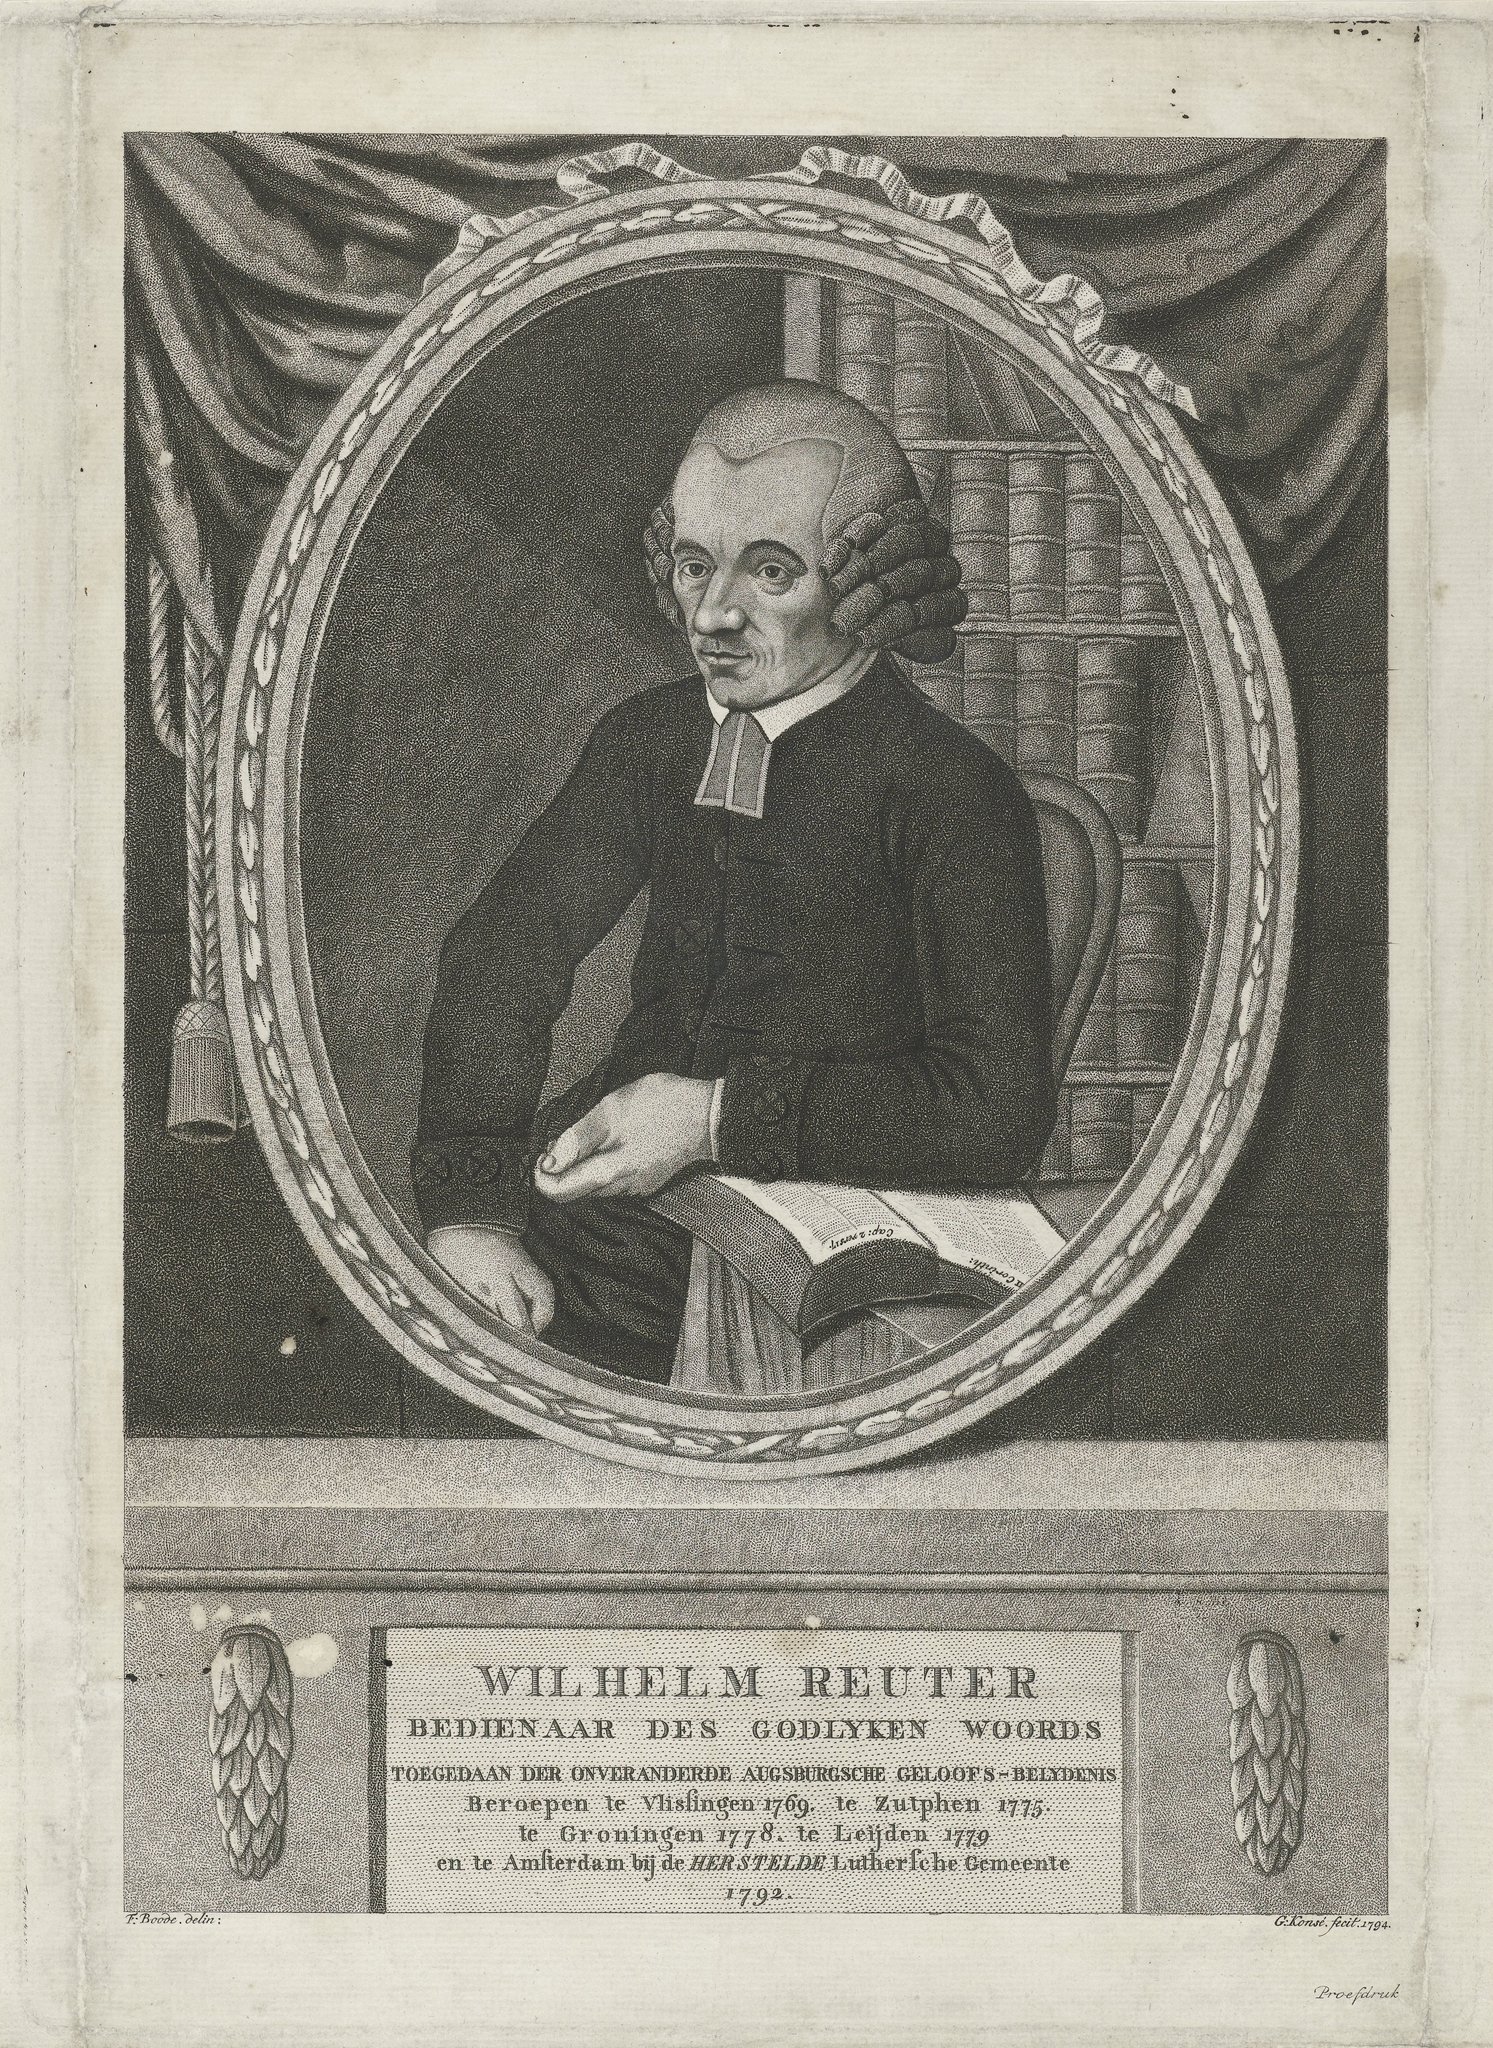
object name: print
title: Portret van Wilhelm Reuter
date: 1794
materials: paper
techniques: etching, engraving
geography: amsterdam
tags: the hague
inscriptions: collector's mark: Lugt 2228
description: Portret van de predikant Wilhelm Reuter, gevat in een ovale omlijsting. Hij draagt een batterijpruik en een bef. Onder zijn linkerarm een opengeslagen bijbel. Onder het portret de naam van de geportretteerde en zes regels tekst.